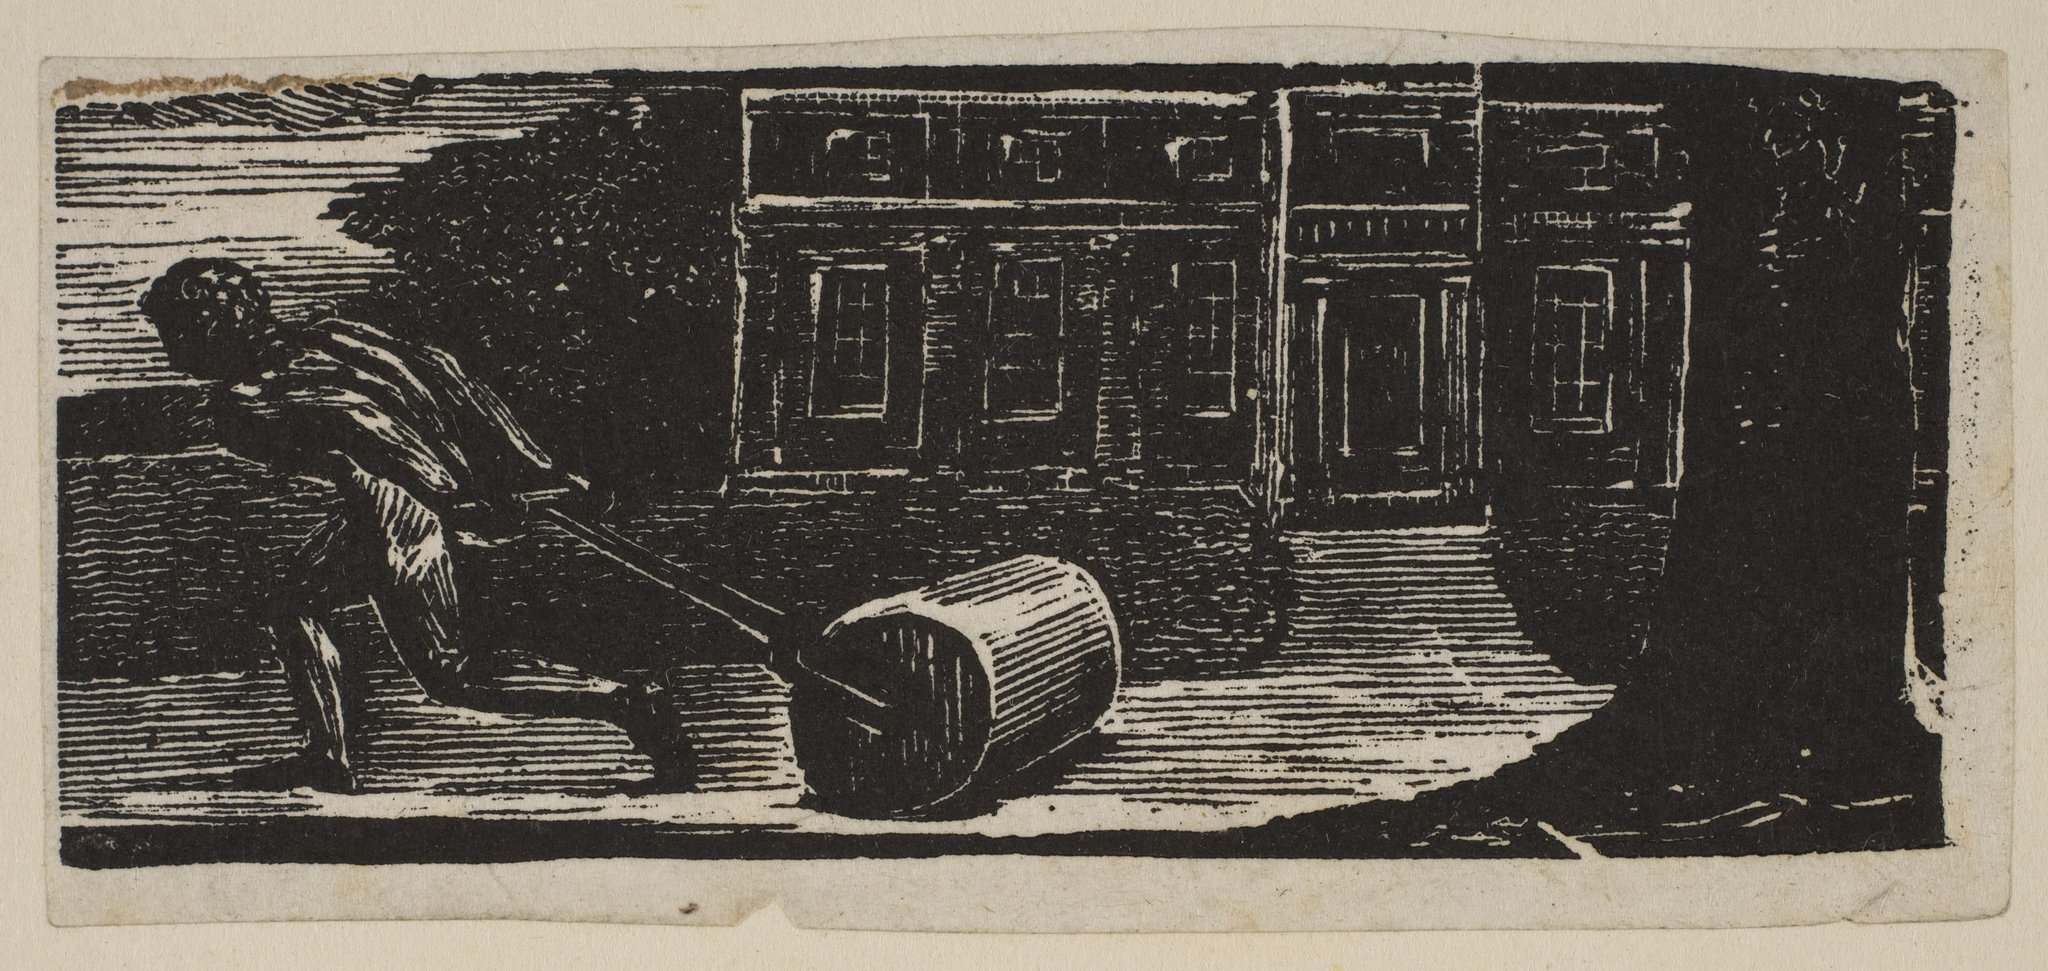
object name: print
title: A Rolling Stone Is Ever Bare of Moss, from Thornton's "Pastorals of Virgil"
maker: william blake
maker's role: artist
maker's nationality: british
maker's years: 1757-1827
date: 1821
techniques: engraving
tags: men,working